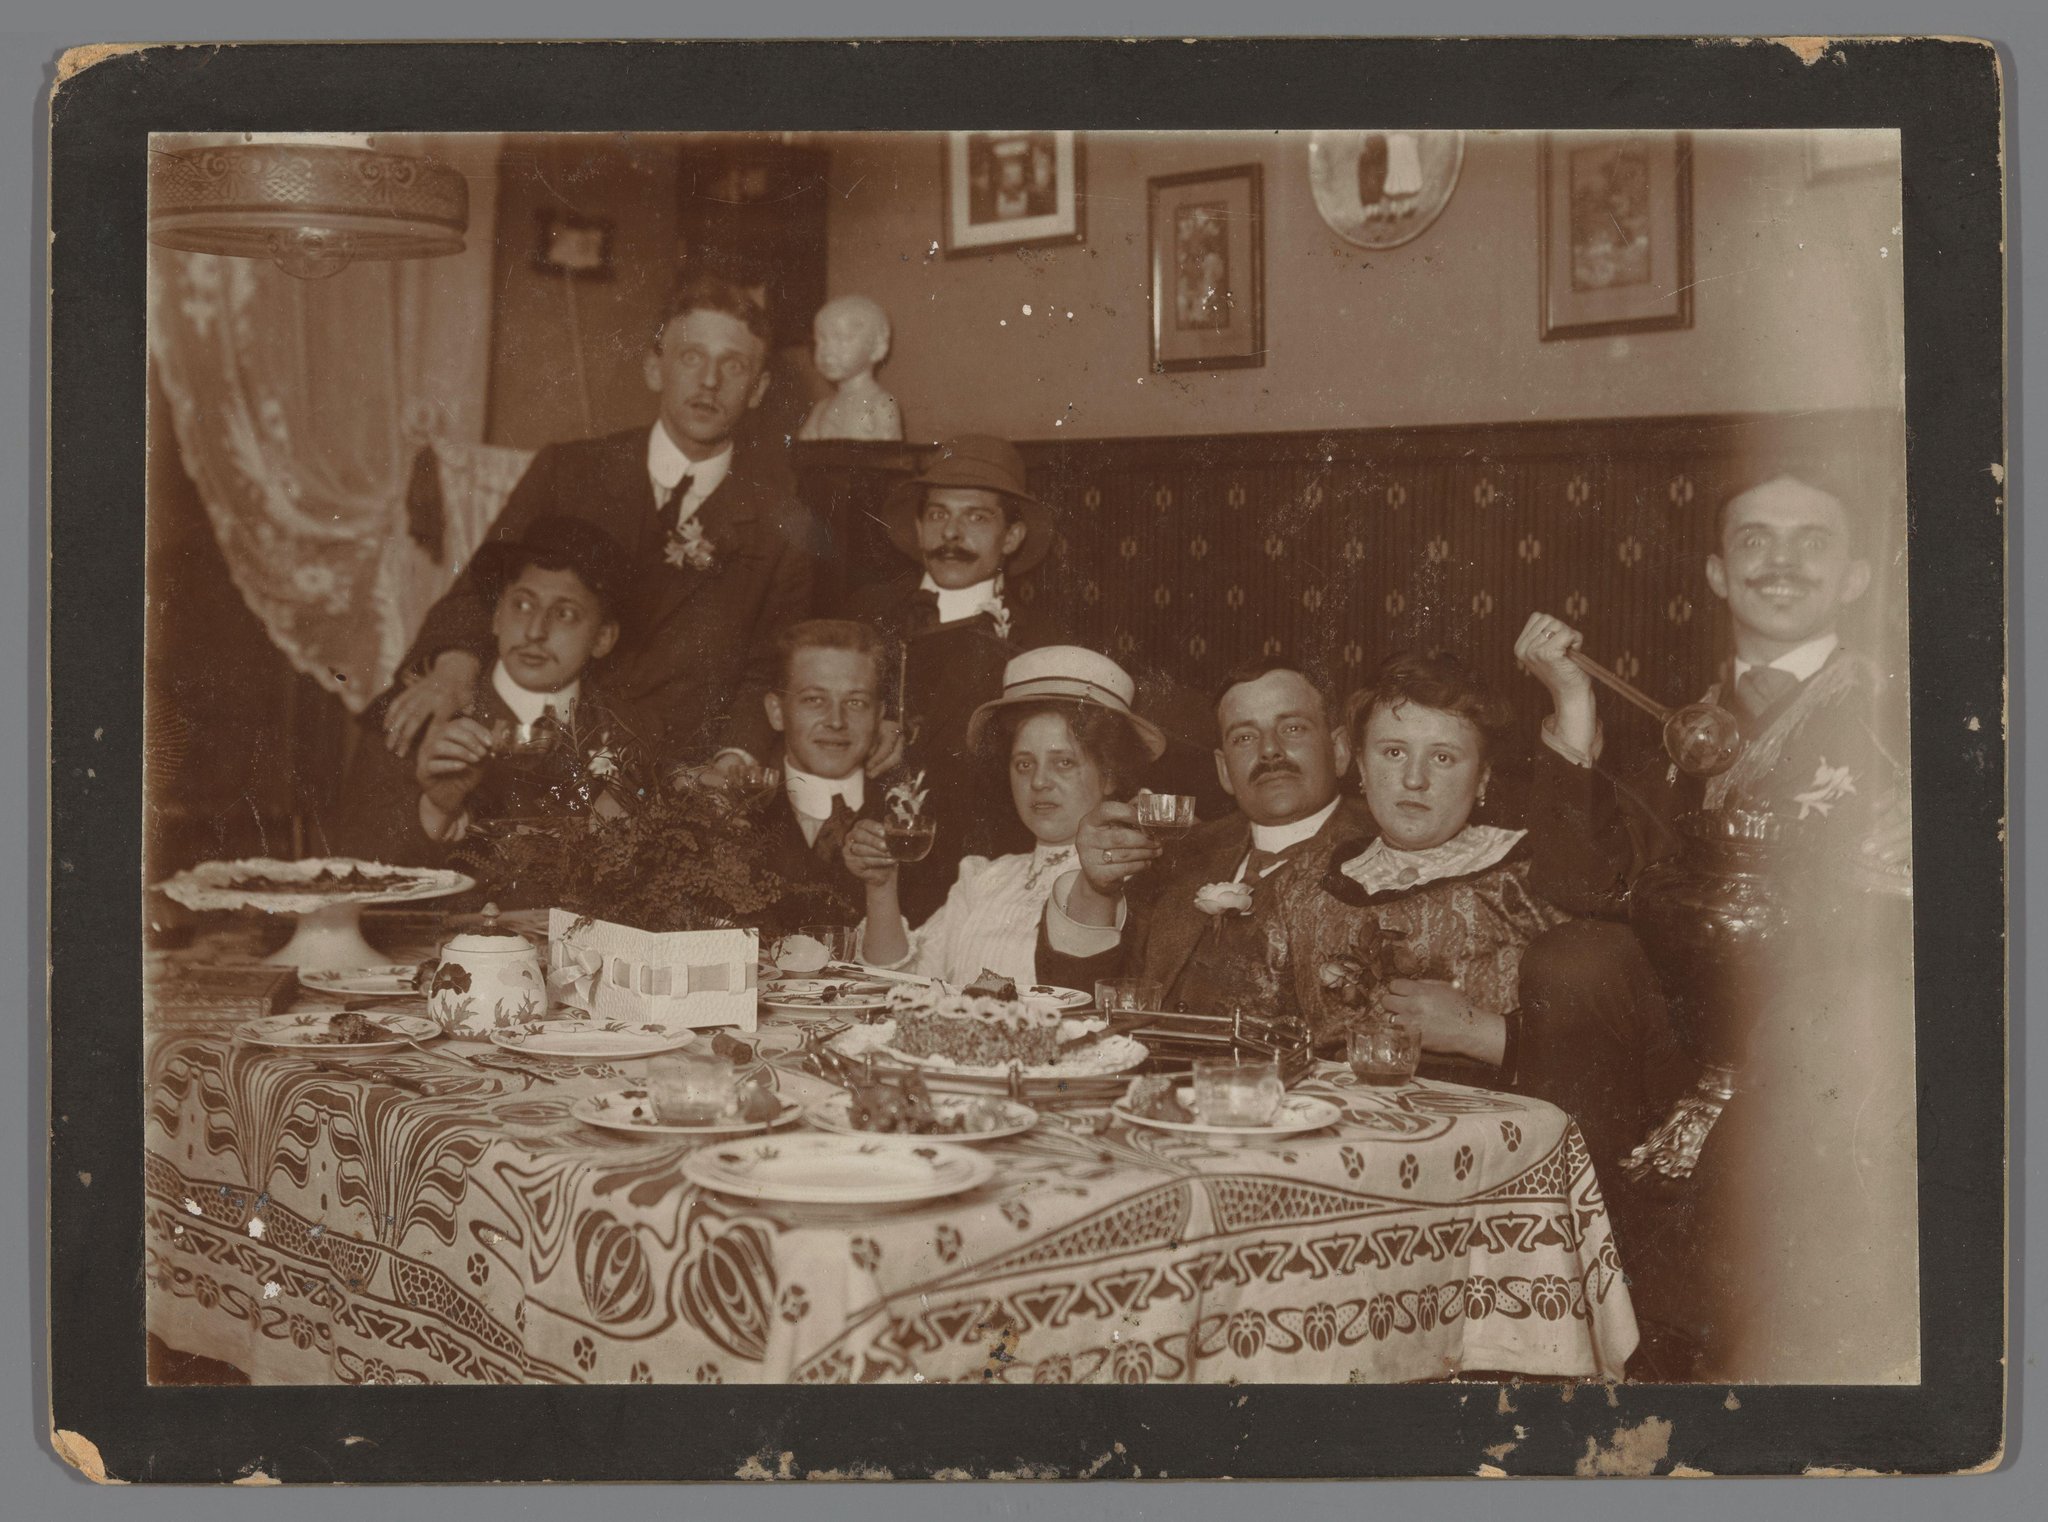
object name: photograph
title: Groepsportret van zes onbekende feestende jongemannen en twee vrouwen, in hotel Scheltema in Amsterdam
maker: Anonymous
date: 1895-1900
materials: paper, cardboard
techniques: gelatin silver print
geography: amsterdam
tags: celebration meal, feast, banquet, anonymous historical persons portrayed in a group, in a group-portrait